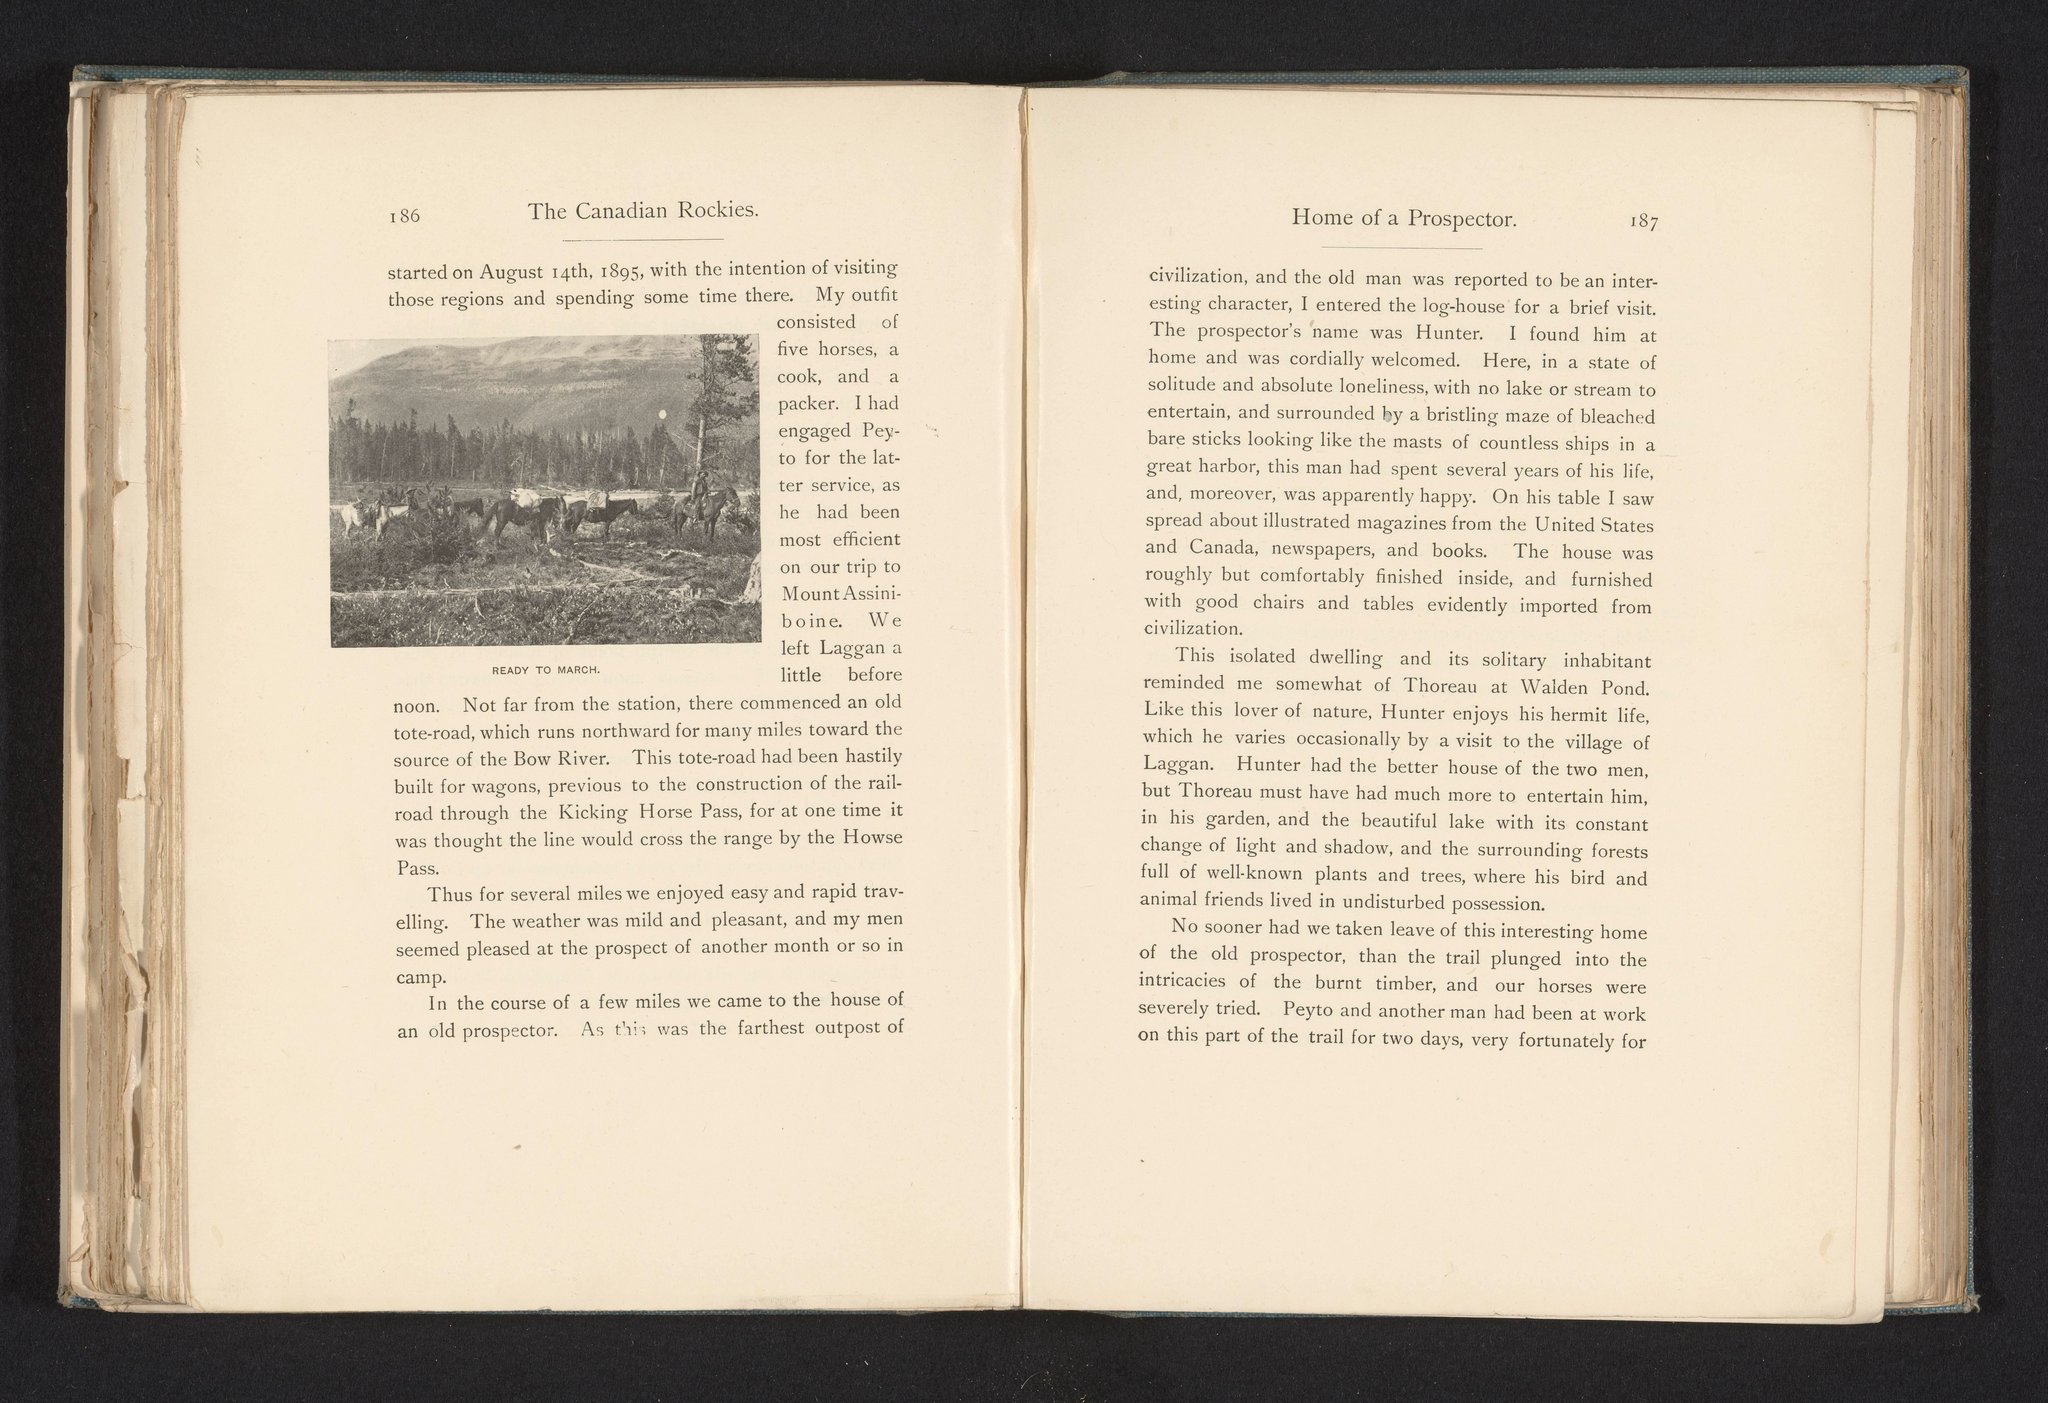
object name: photomechanical print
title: Expeditie met paarden in een dal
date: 1893-1897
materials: paper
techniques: autotype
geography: canada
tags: dale, valley, horse